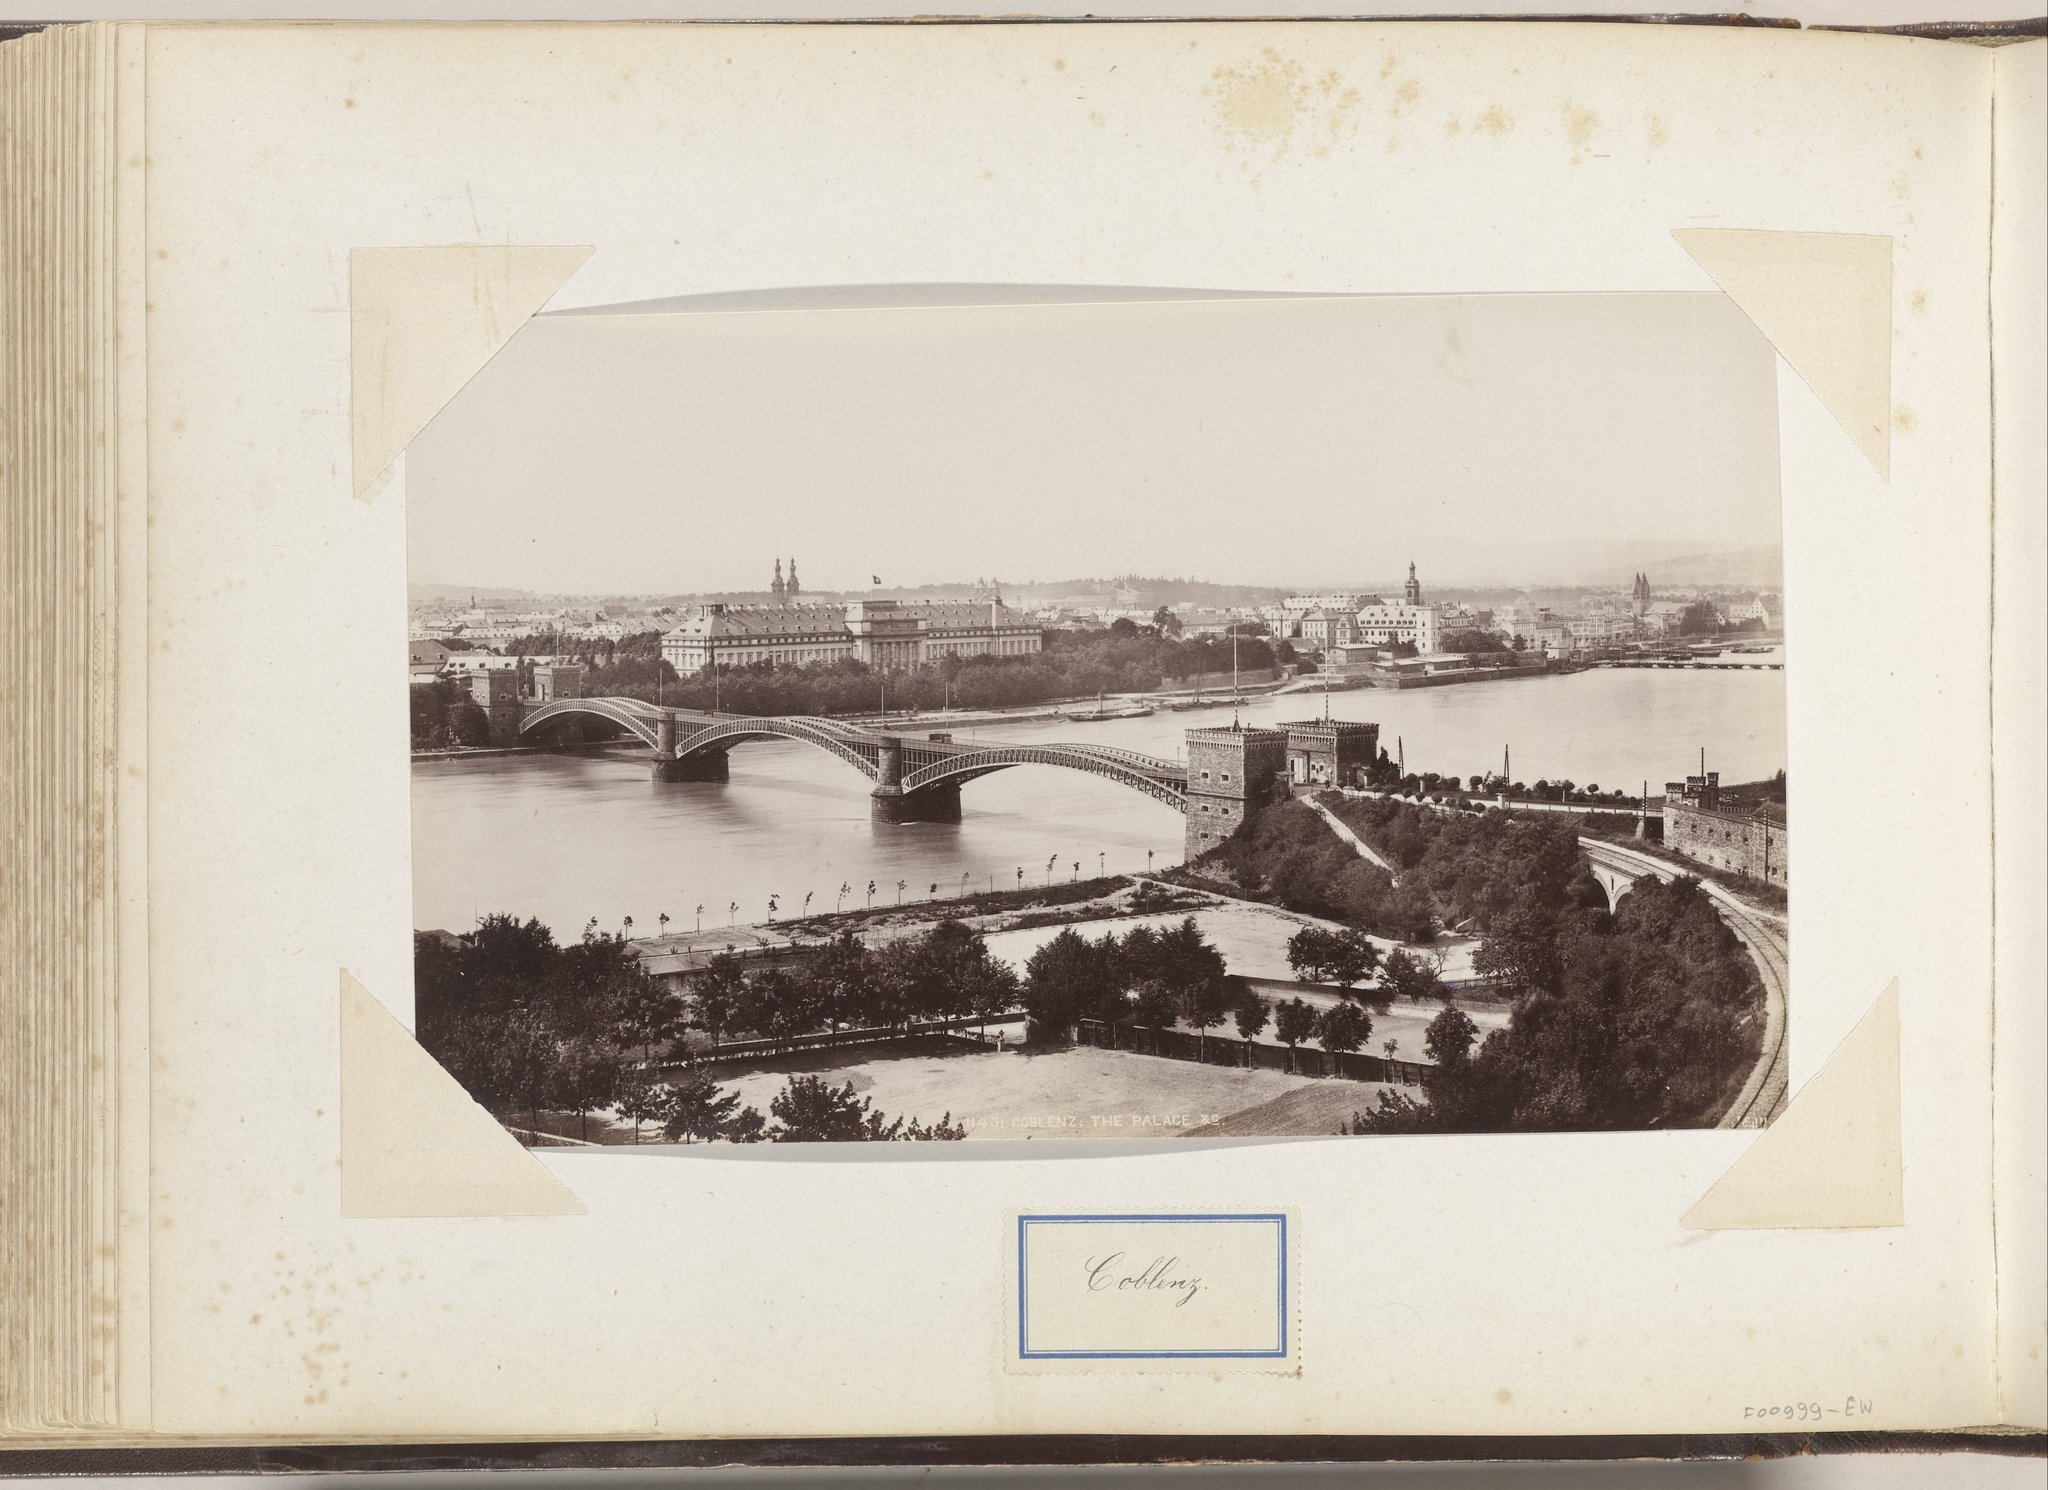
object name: photograph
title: Gezicht op een spoorbrug en een paleis in Koblenz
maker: Anonymous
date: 1860-1900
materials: paper, photographic support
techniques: albumen print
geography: koblenz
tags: palace, bridge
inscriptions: negative number: ‘11431’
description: Onderdeel van Album met 191 foto's van een reis naar en door Zuid-Afrika.